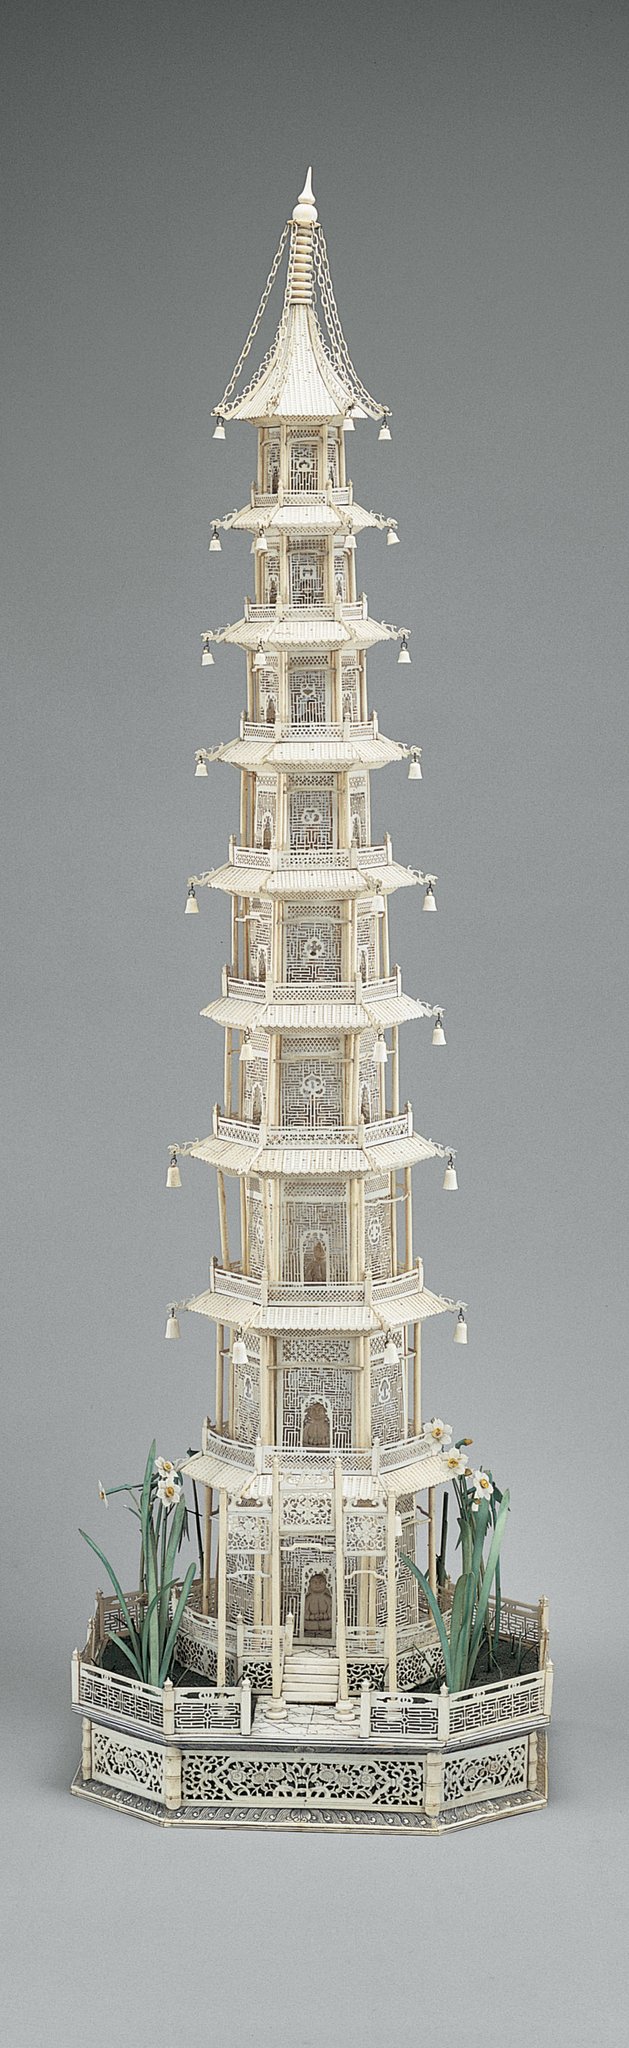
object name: pagoda and case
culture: chinese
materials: ivory, wood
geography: china